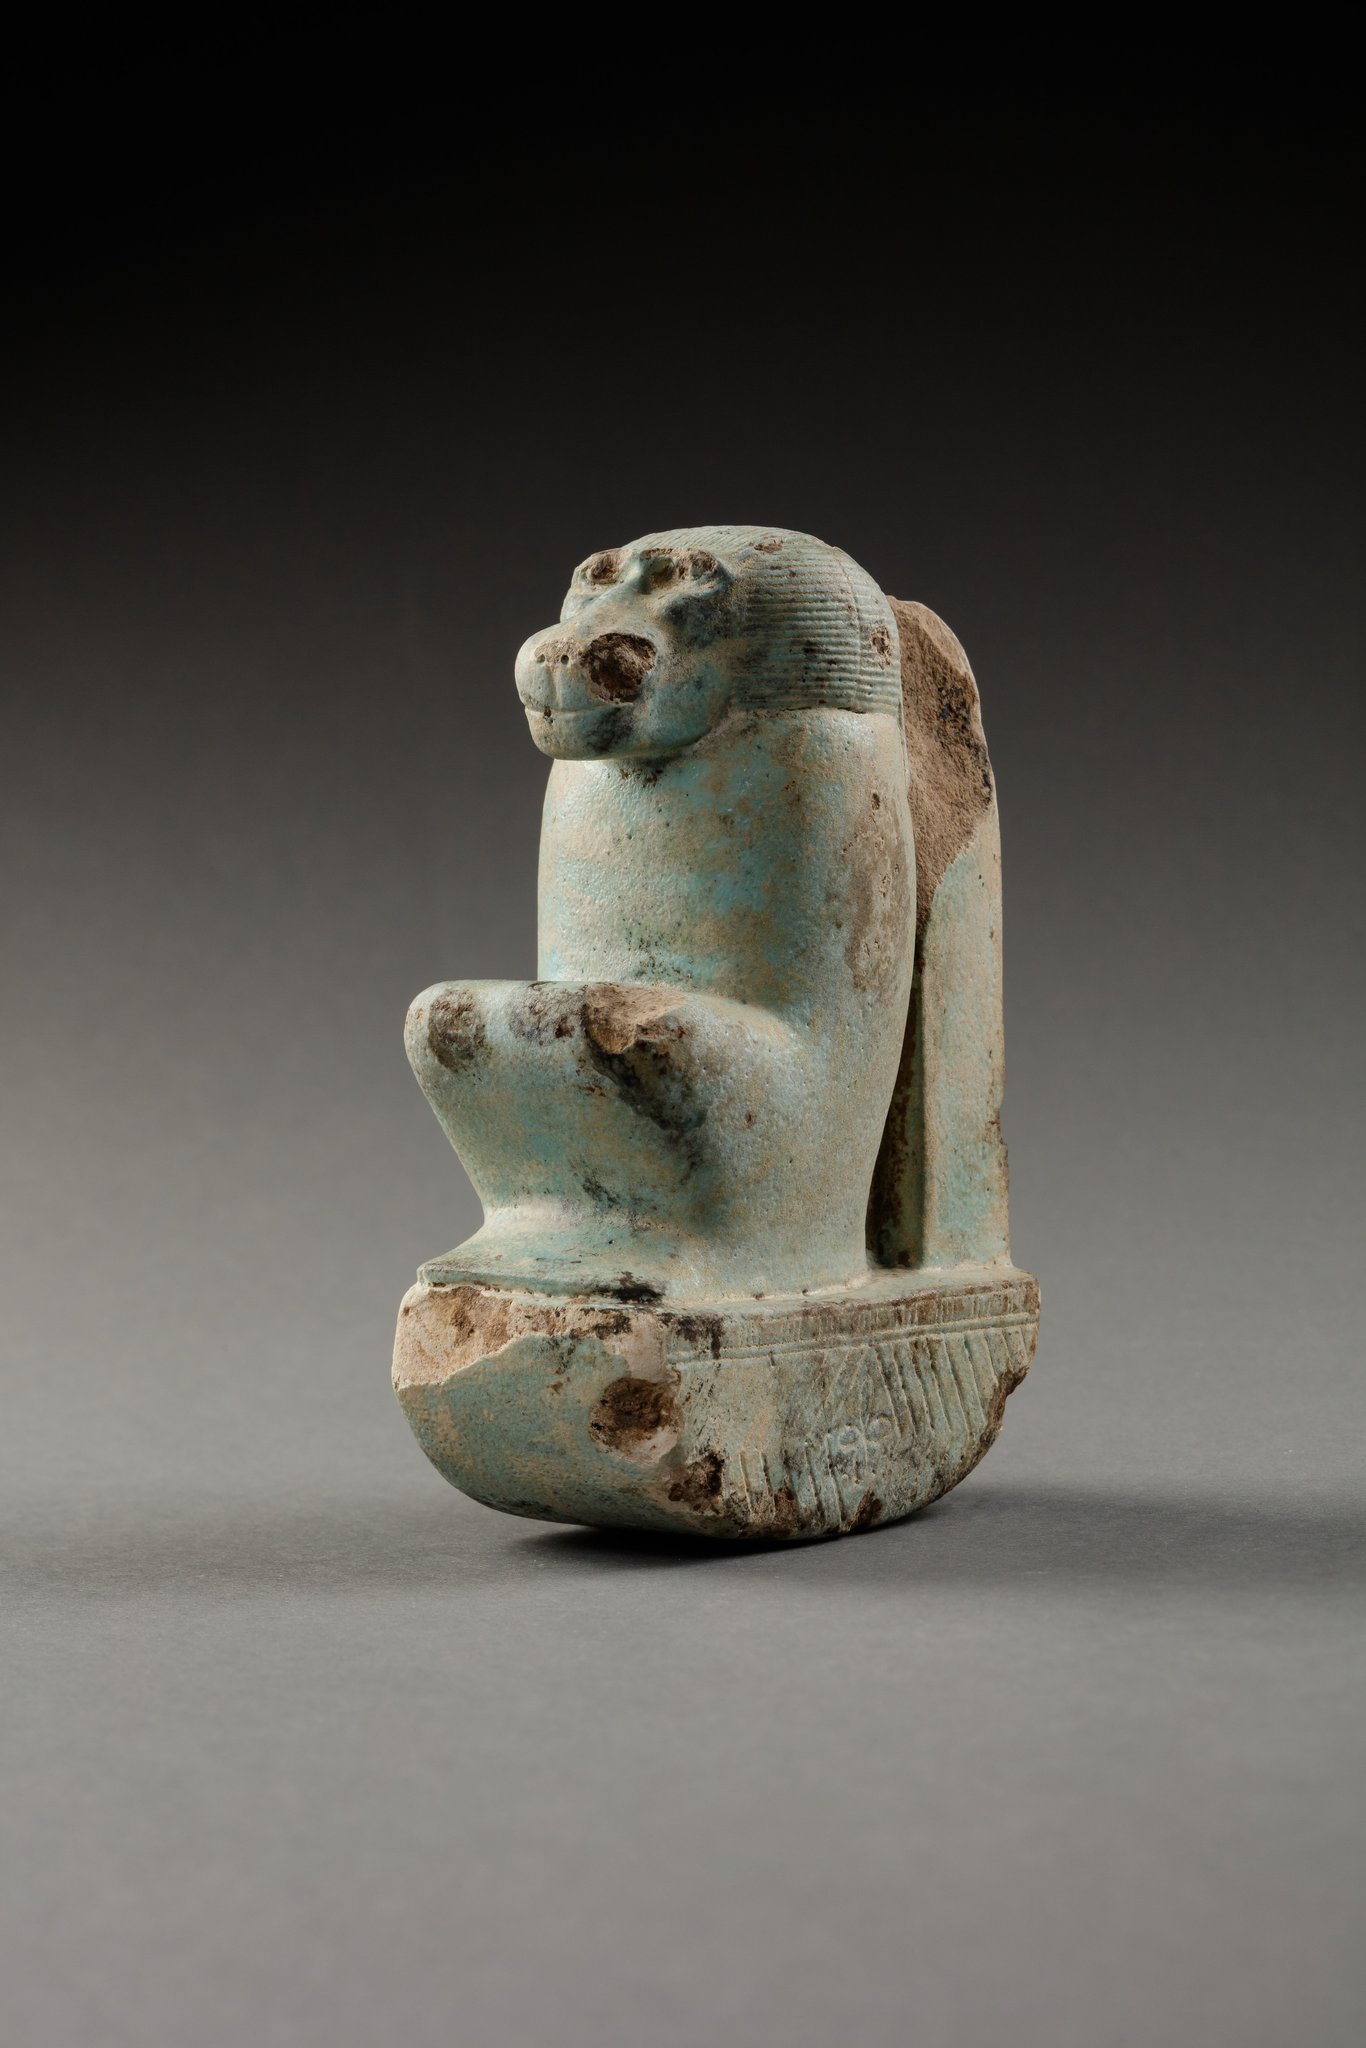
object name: baboon, squatting, shebet, basket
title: Figure of baboon on a basket and with a pillar, the shebet offering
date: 664-630 BCE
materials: faience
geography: egypt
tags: baboons